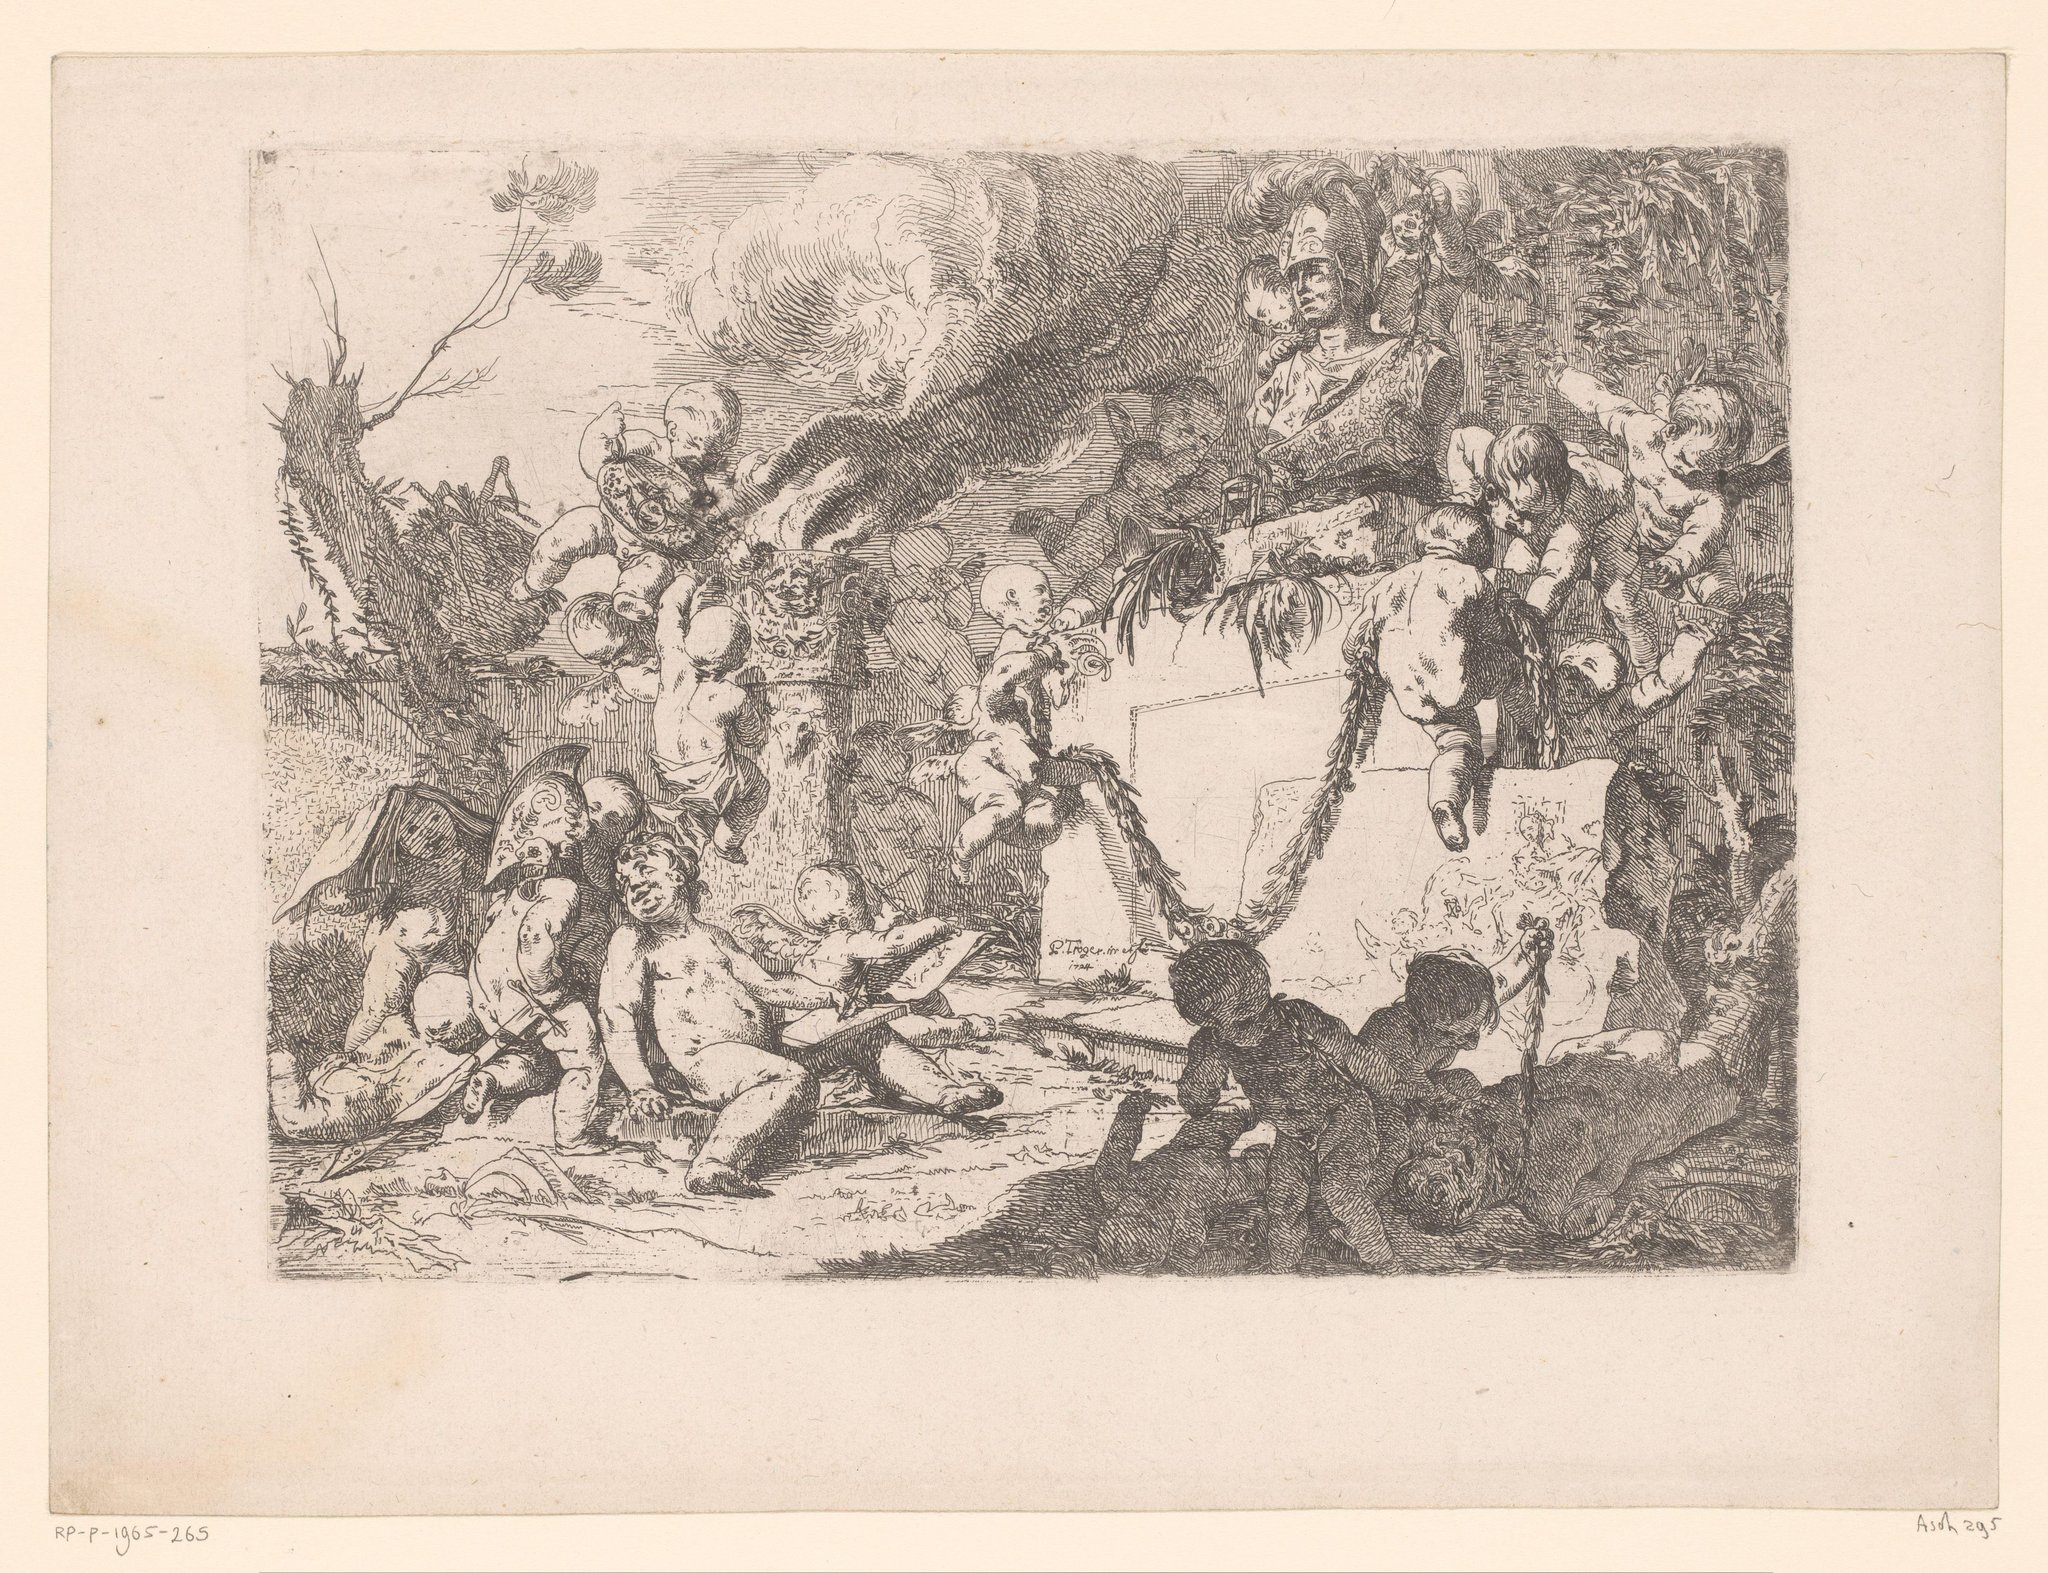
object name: print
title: Putti bij een heiligdom van Minerva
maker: paul troger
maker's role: print maker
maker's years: 1698-1762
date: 1724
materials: paper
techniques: drypoint, etching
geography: italy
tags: (story of) minerva (pallas, athena), piece of sculpture, reproduction of a piece of sculpture, attributes of minerva, draughtsman at work - cc - out of doors, cupids: 'amores', 'amoretti', 'putti', altar ~ roman religion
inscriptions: collector's mark: ‘G’, collector's mark: Lugt 2228